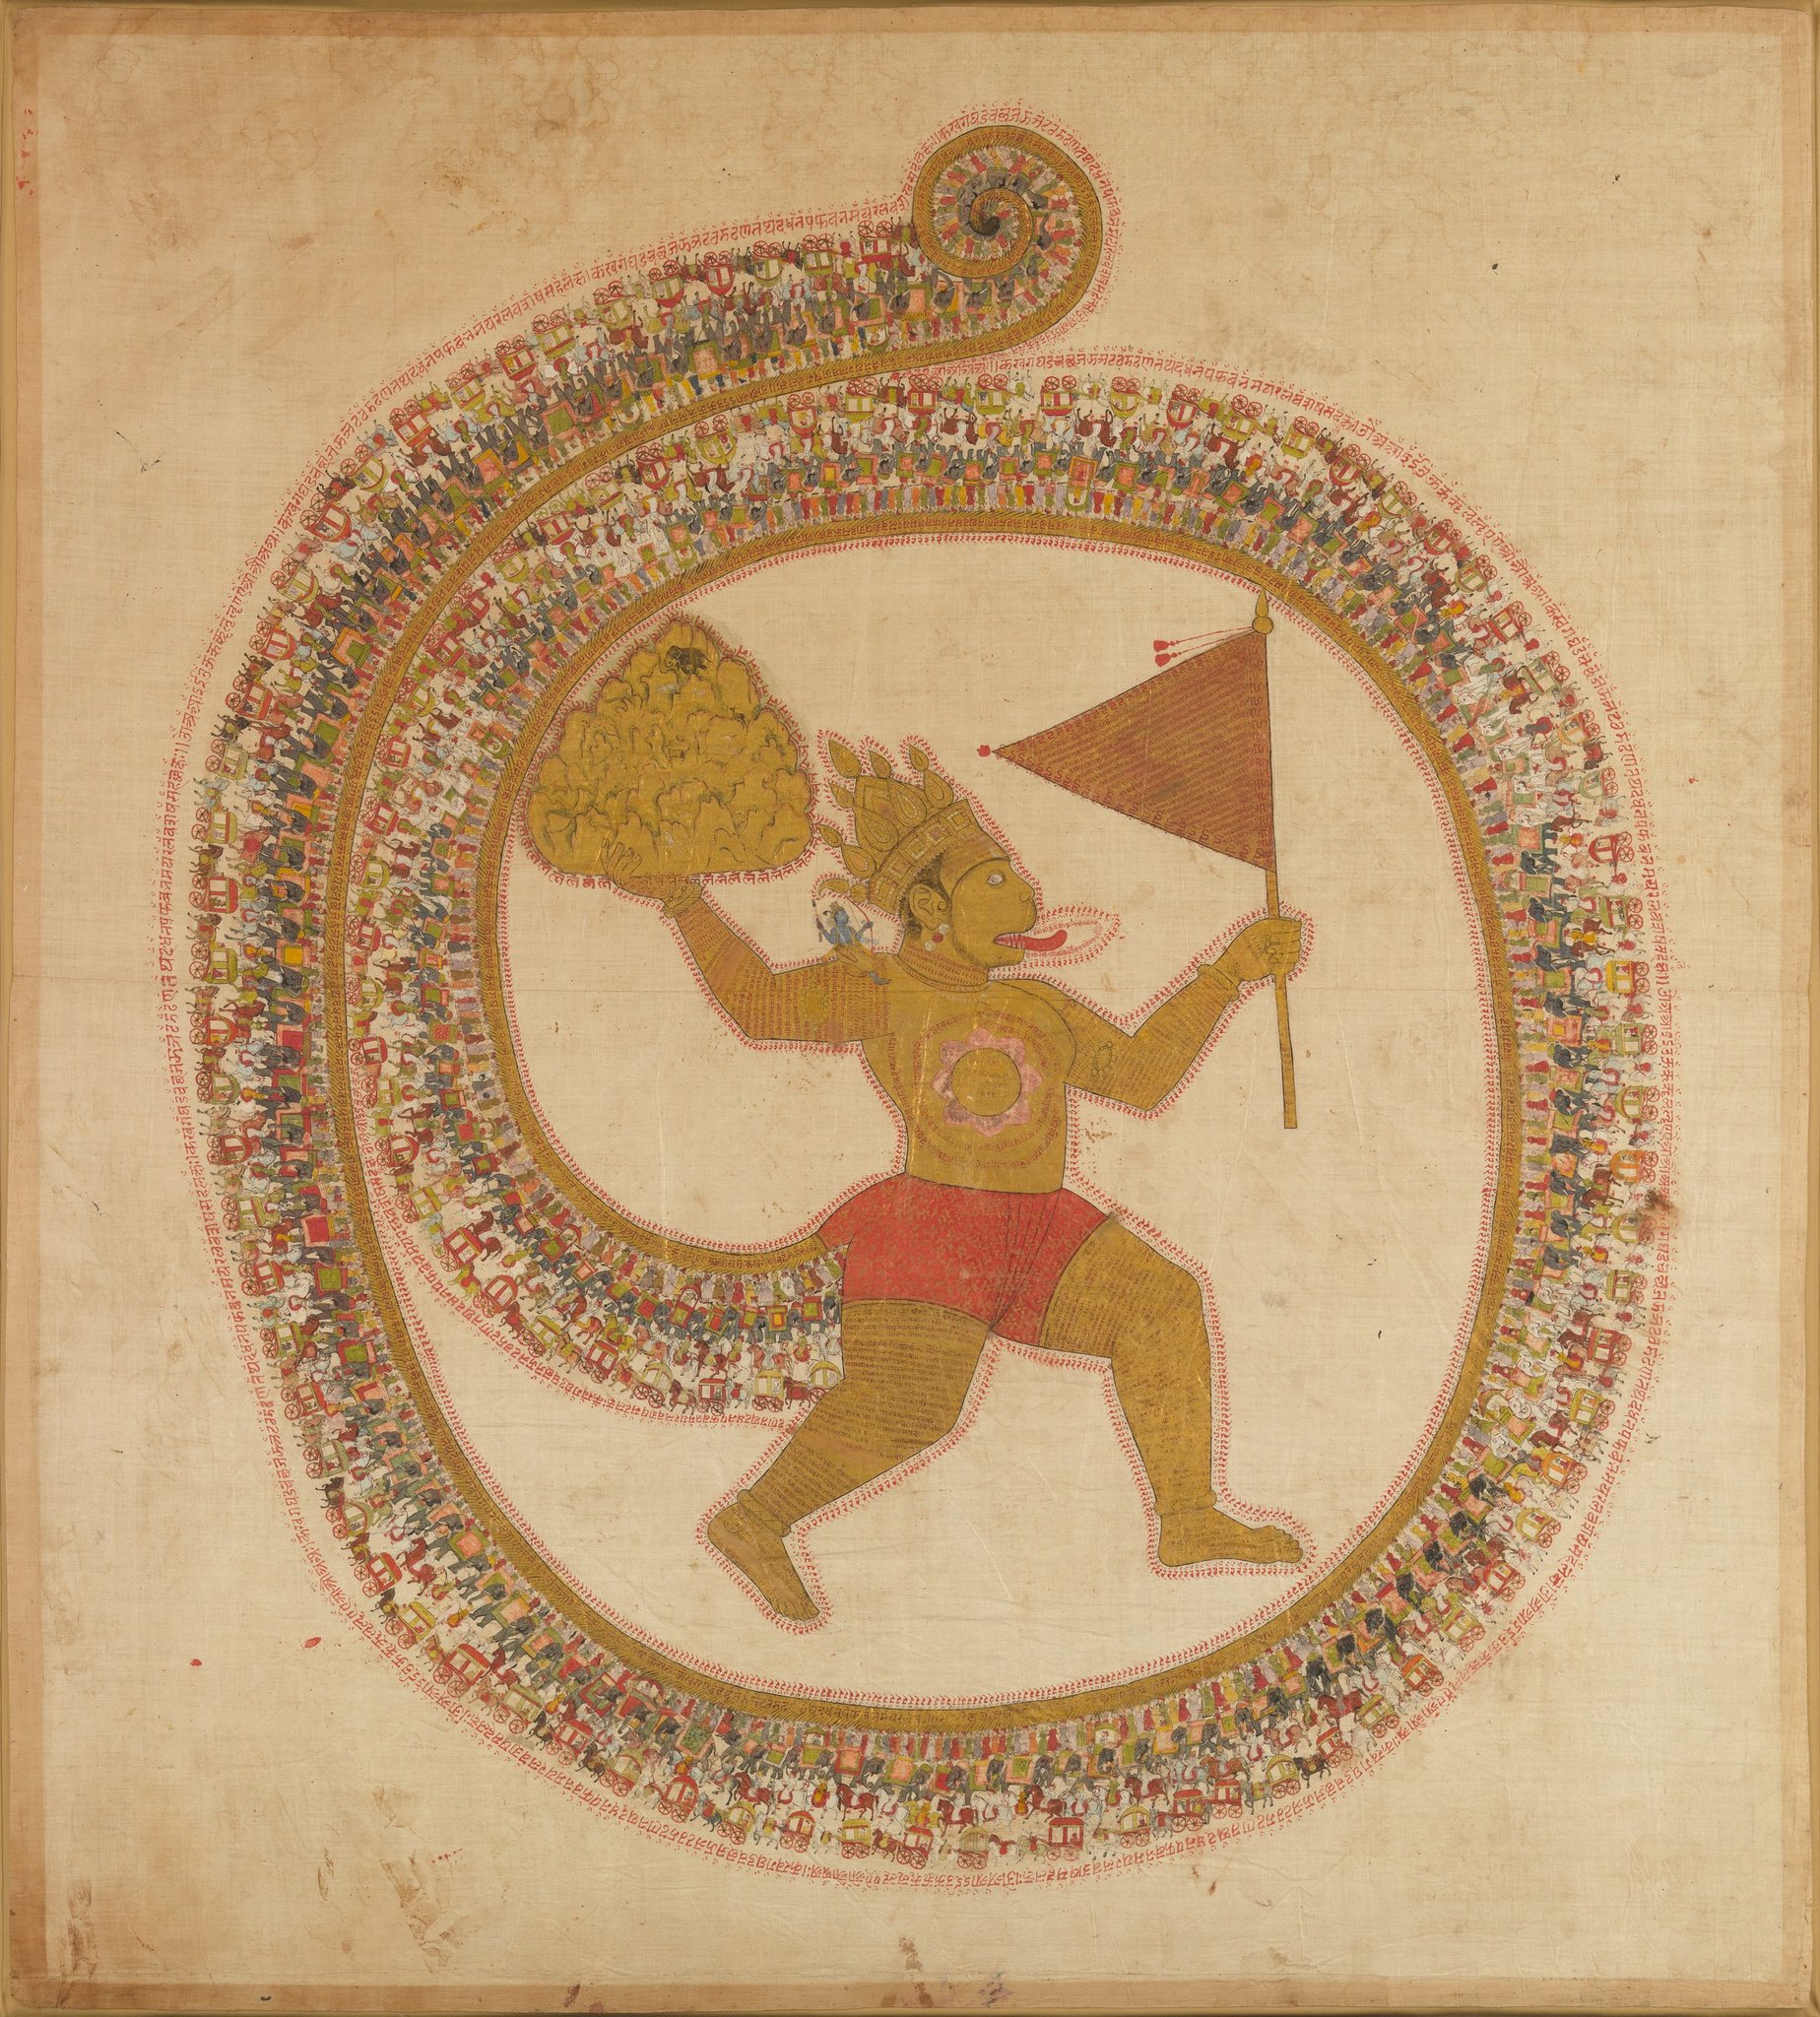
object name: painting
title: Hanuman Bearing the Mountaintop with Medicinal Herbs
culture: indian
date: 1800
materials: textile, ink, watercolor